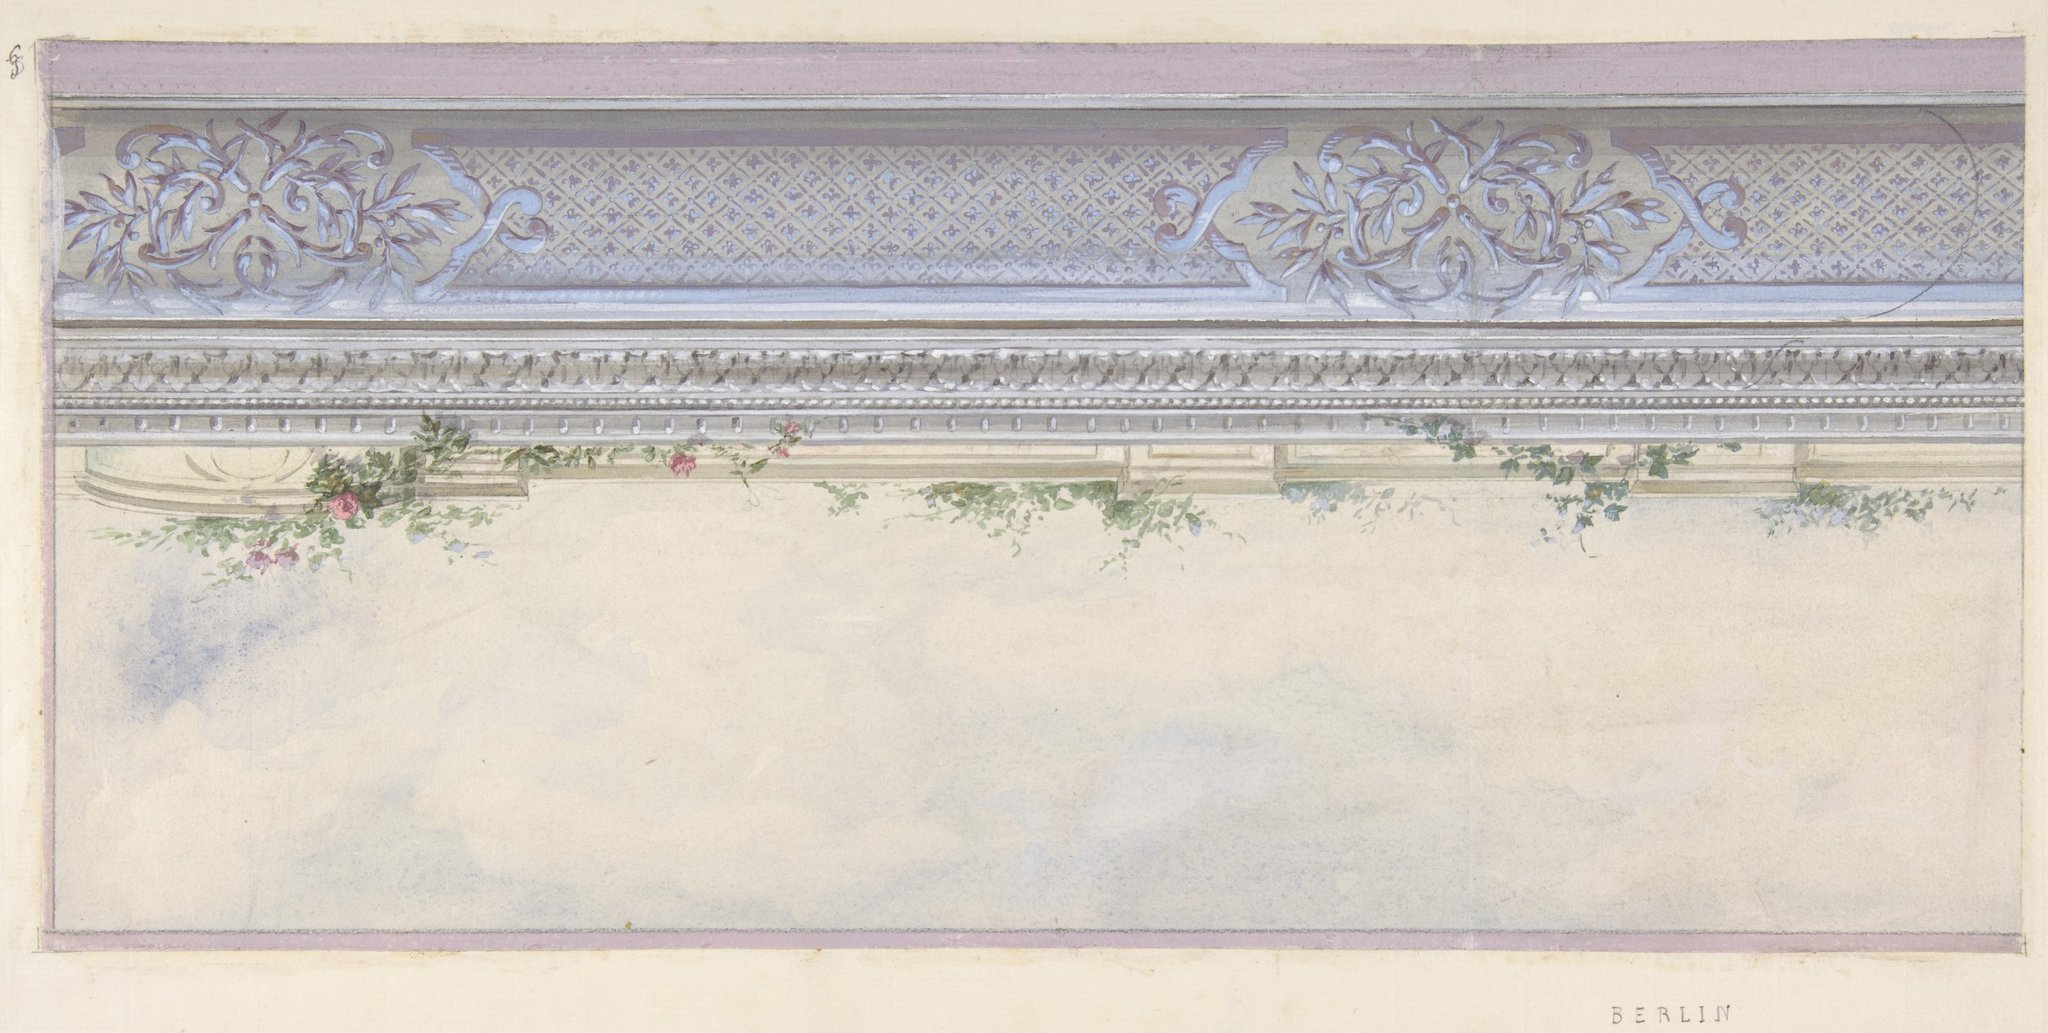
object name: drawing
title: Design for the Decoration of a Ceiling Cove in the Hôtel de Pless, Berlin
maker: jules-edmond-charles lachaise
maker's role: artist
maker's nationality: french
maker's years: 1897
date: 1851-1900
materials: gouache, watercolor, paper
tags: ceilings